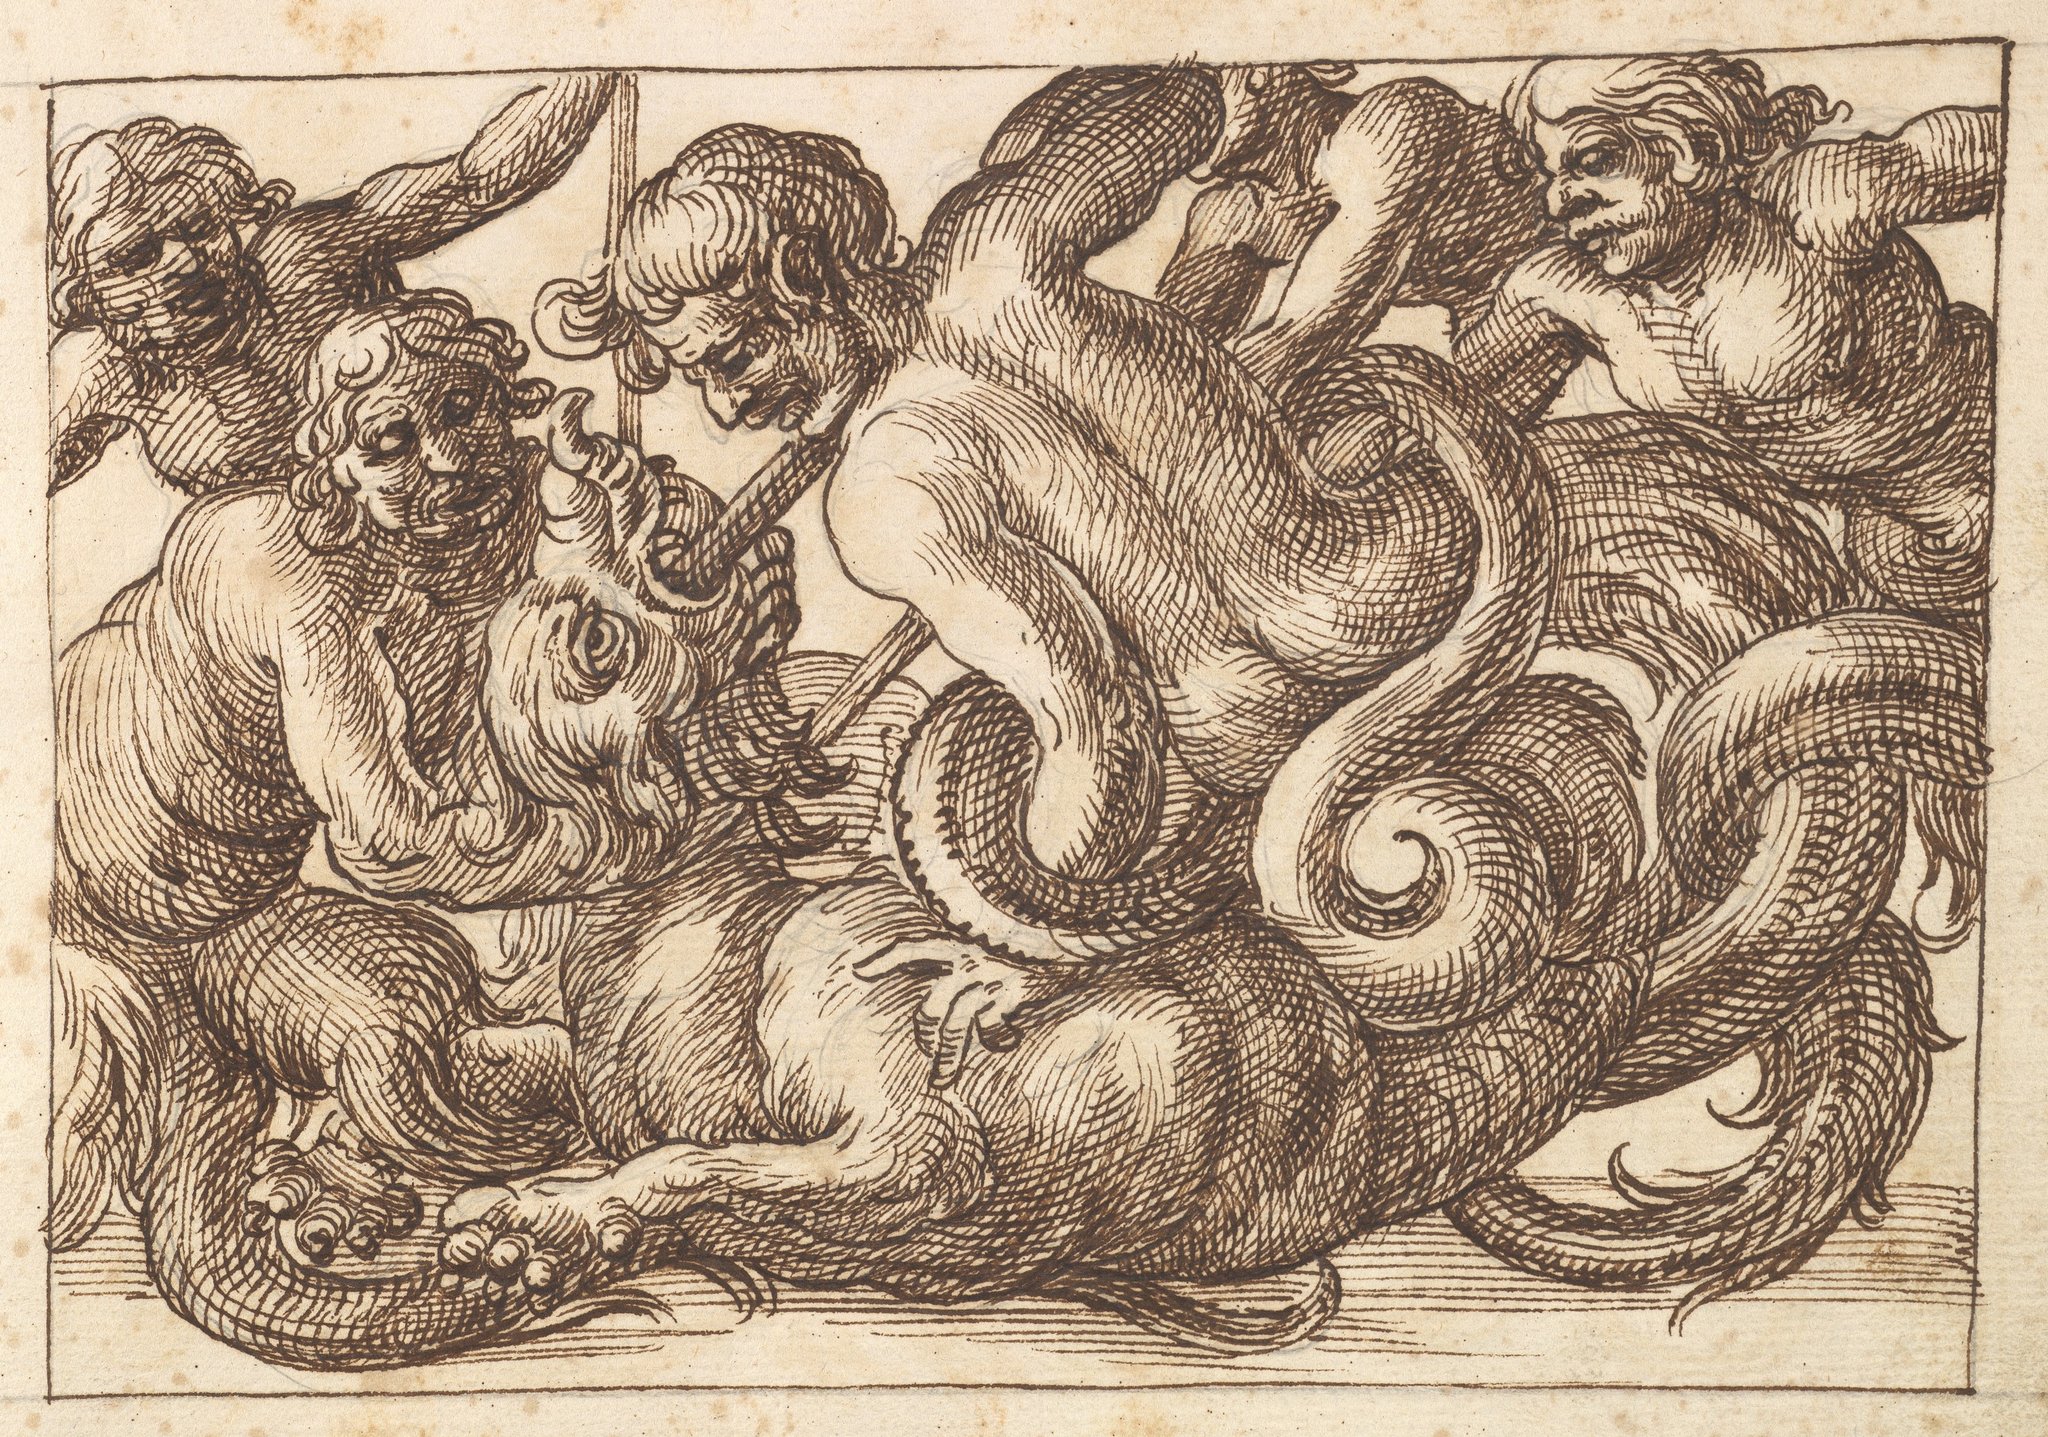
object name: collection ornament architecture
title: Horizontal Panel Design with Five Male Figures Fighting a Dragon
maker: anonymous, italian, venetian, 17th century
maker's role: artist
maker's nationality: italian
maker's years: 1600-1700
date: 1601-1700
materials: ink, drawing material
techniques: pen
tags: men,dragons